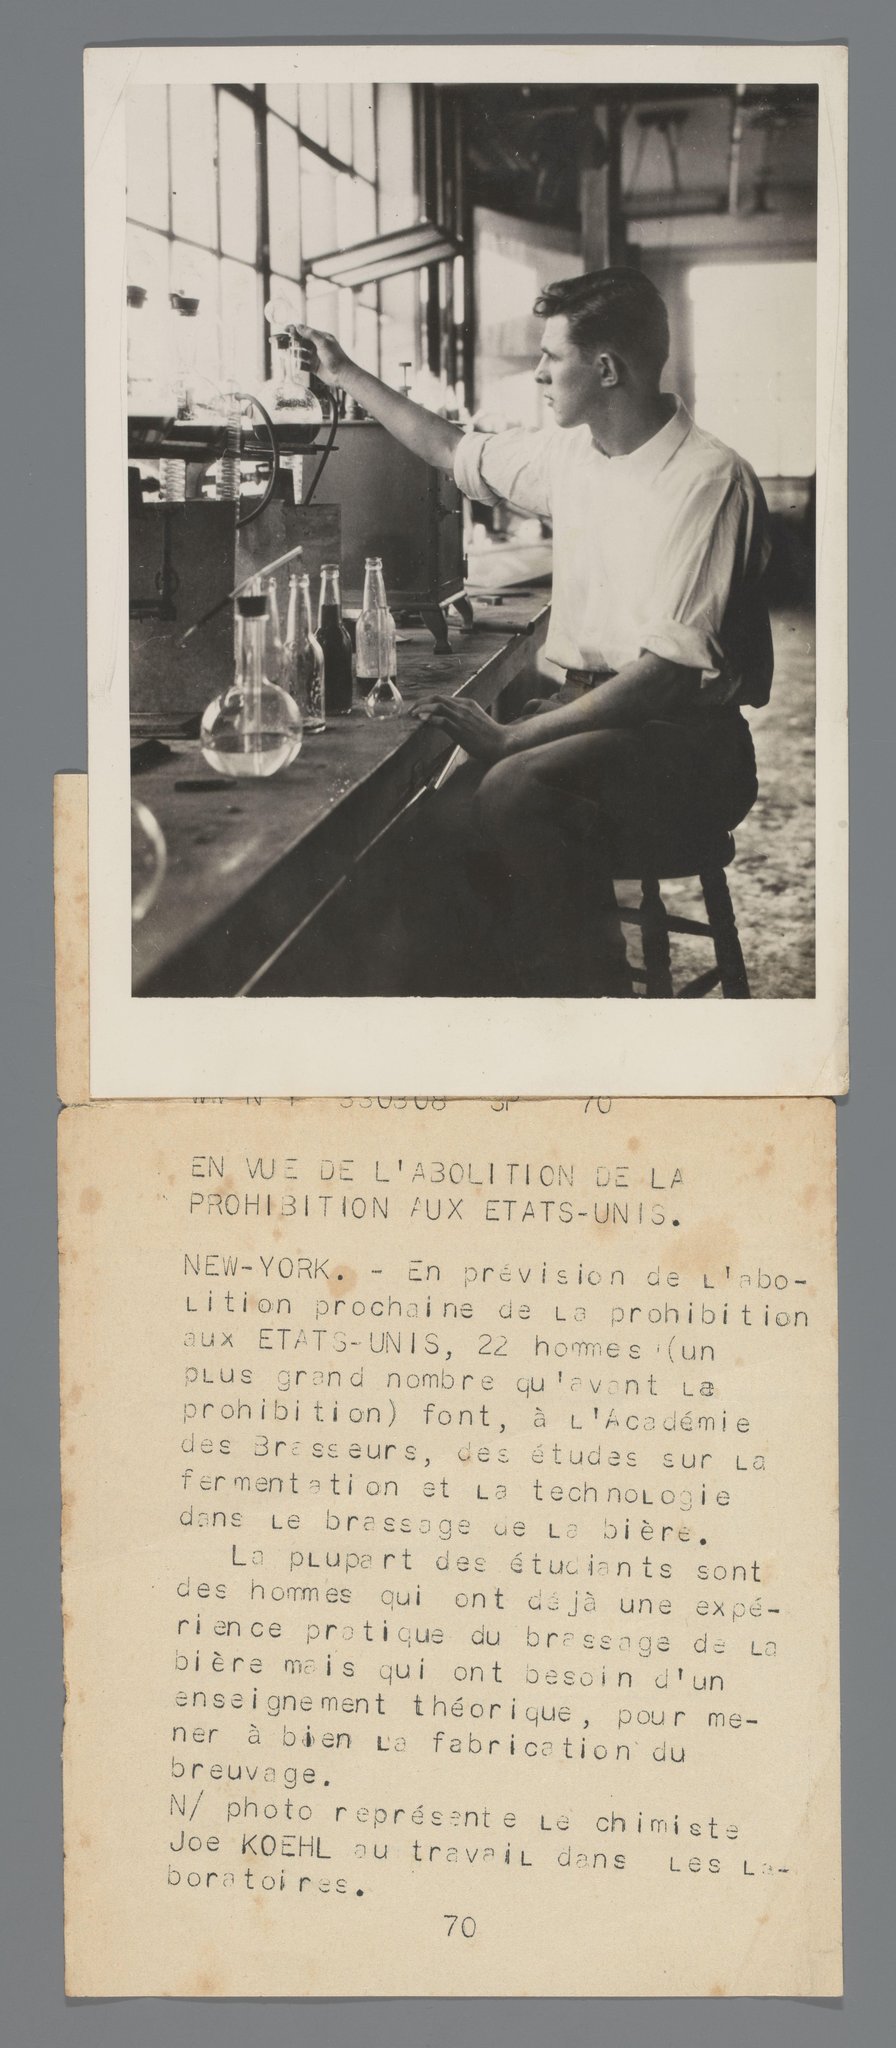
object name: photograph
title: Chemicus Joe Koehl in een laboratorium aan het werk om de fermentatie en het brouwproces van bier te bestuderen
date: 1933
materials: paper, photographic support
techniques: gelatin silver print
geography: united states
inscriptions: : ‘WIDE WORLD PHOTOS / THE NEW-YORK TIMES, S.A. / SIÈGE SOCIAL / 106, Rue Reaumur, 106 / PARIS […]’, label: ‘WW N Y 330308 SP 70 / EN VUE DE L’ABOLITION AUX ETATS-UNIS. / […] photo représente le chimiste Joe KOEHL au travail dans les laboratoires.’